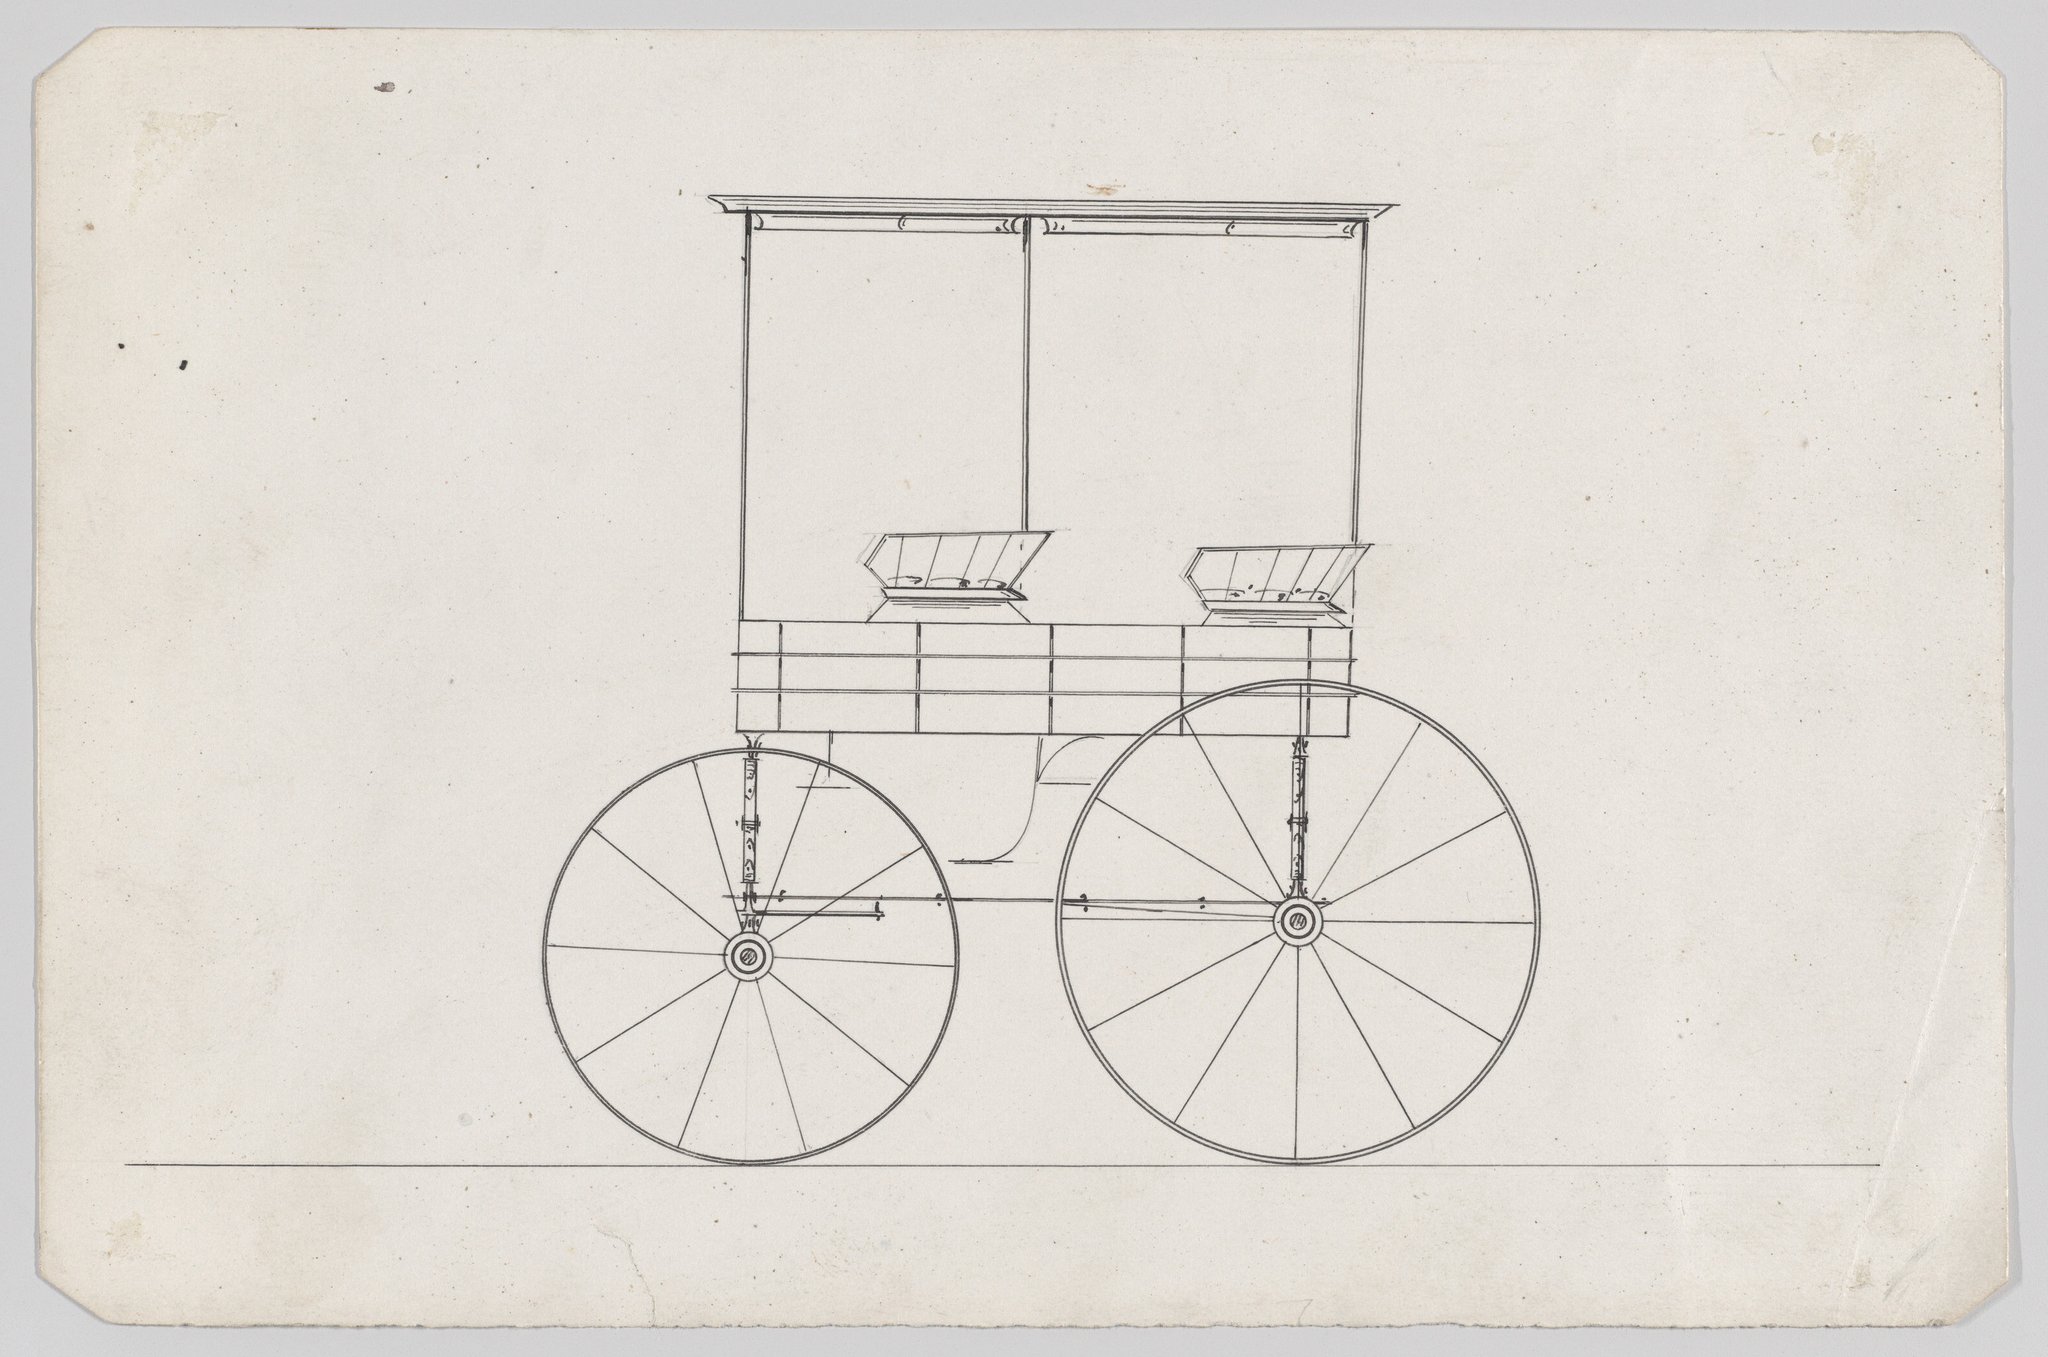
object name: drawing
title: Design for Jersey Wagon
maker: brewster & co.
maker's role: manufacturer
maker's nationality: american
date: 1850-1870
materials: ink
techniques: pen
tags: carriages